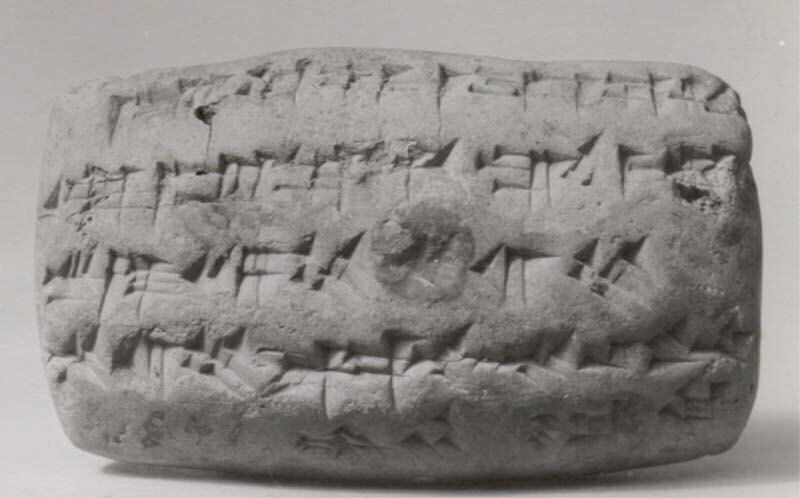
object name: cuneiform tablet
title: Cuneiform tablet: promissory note for silver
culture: assyrian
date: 656 BCE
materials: clay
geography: mesopotamia